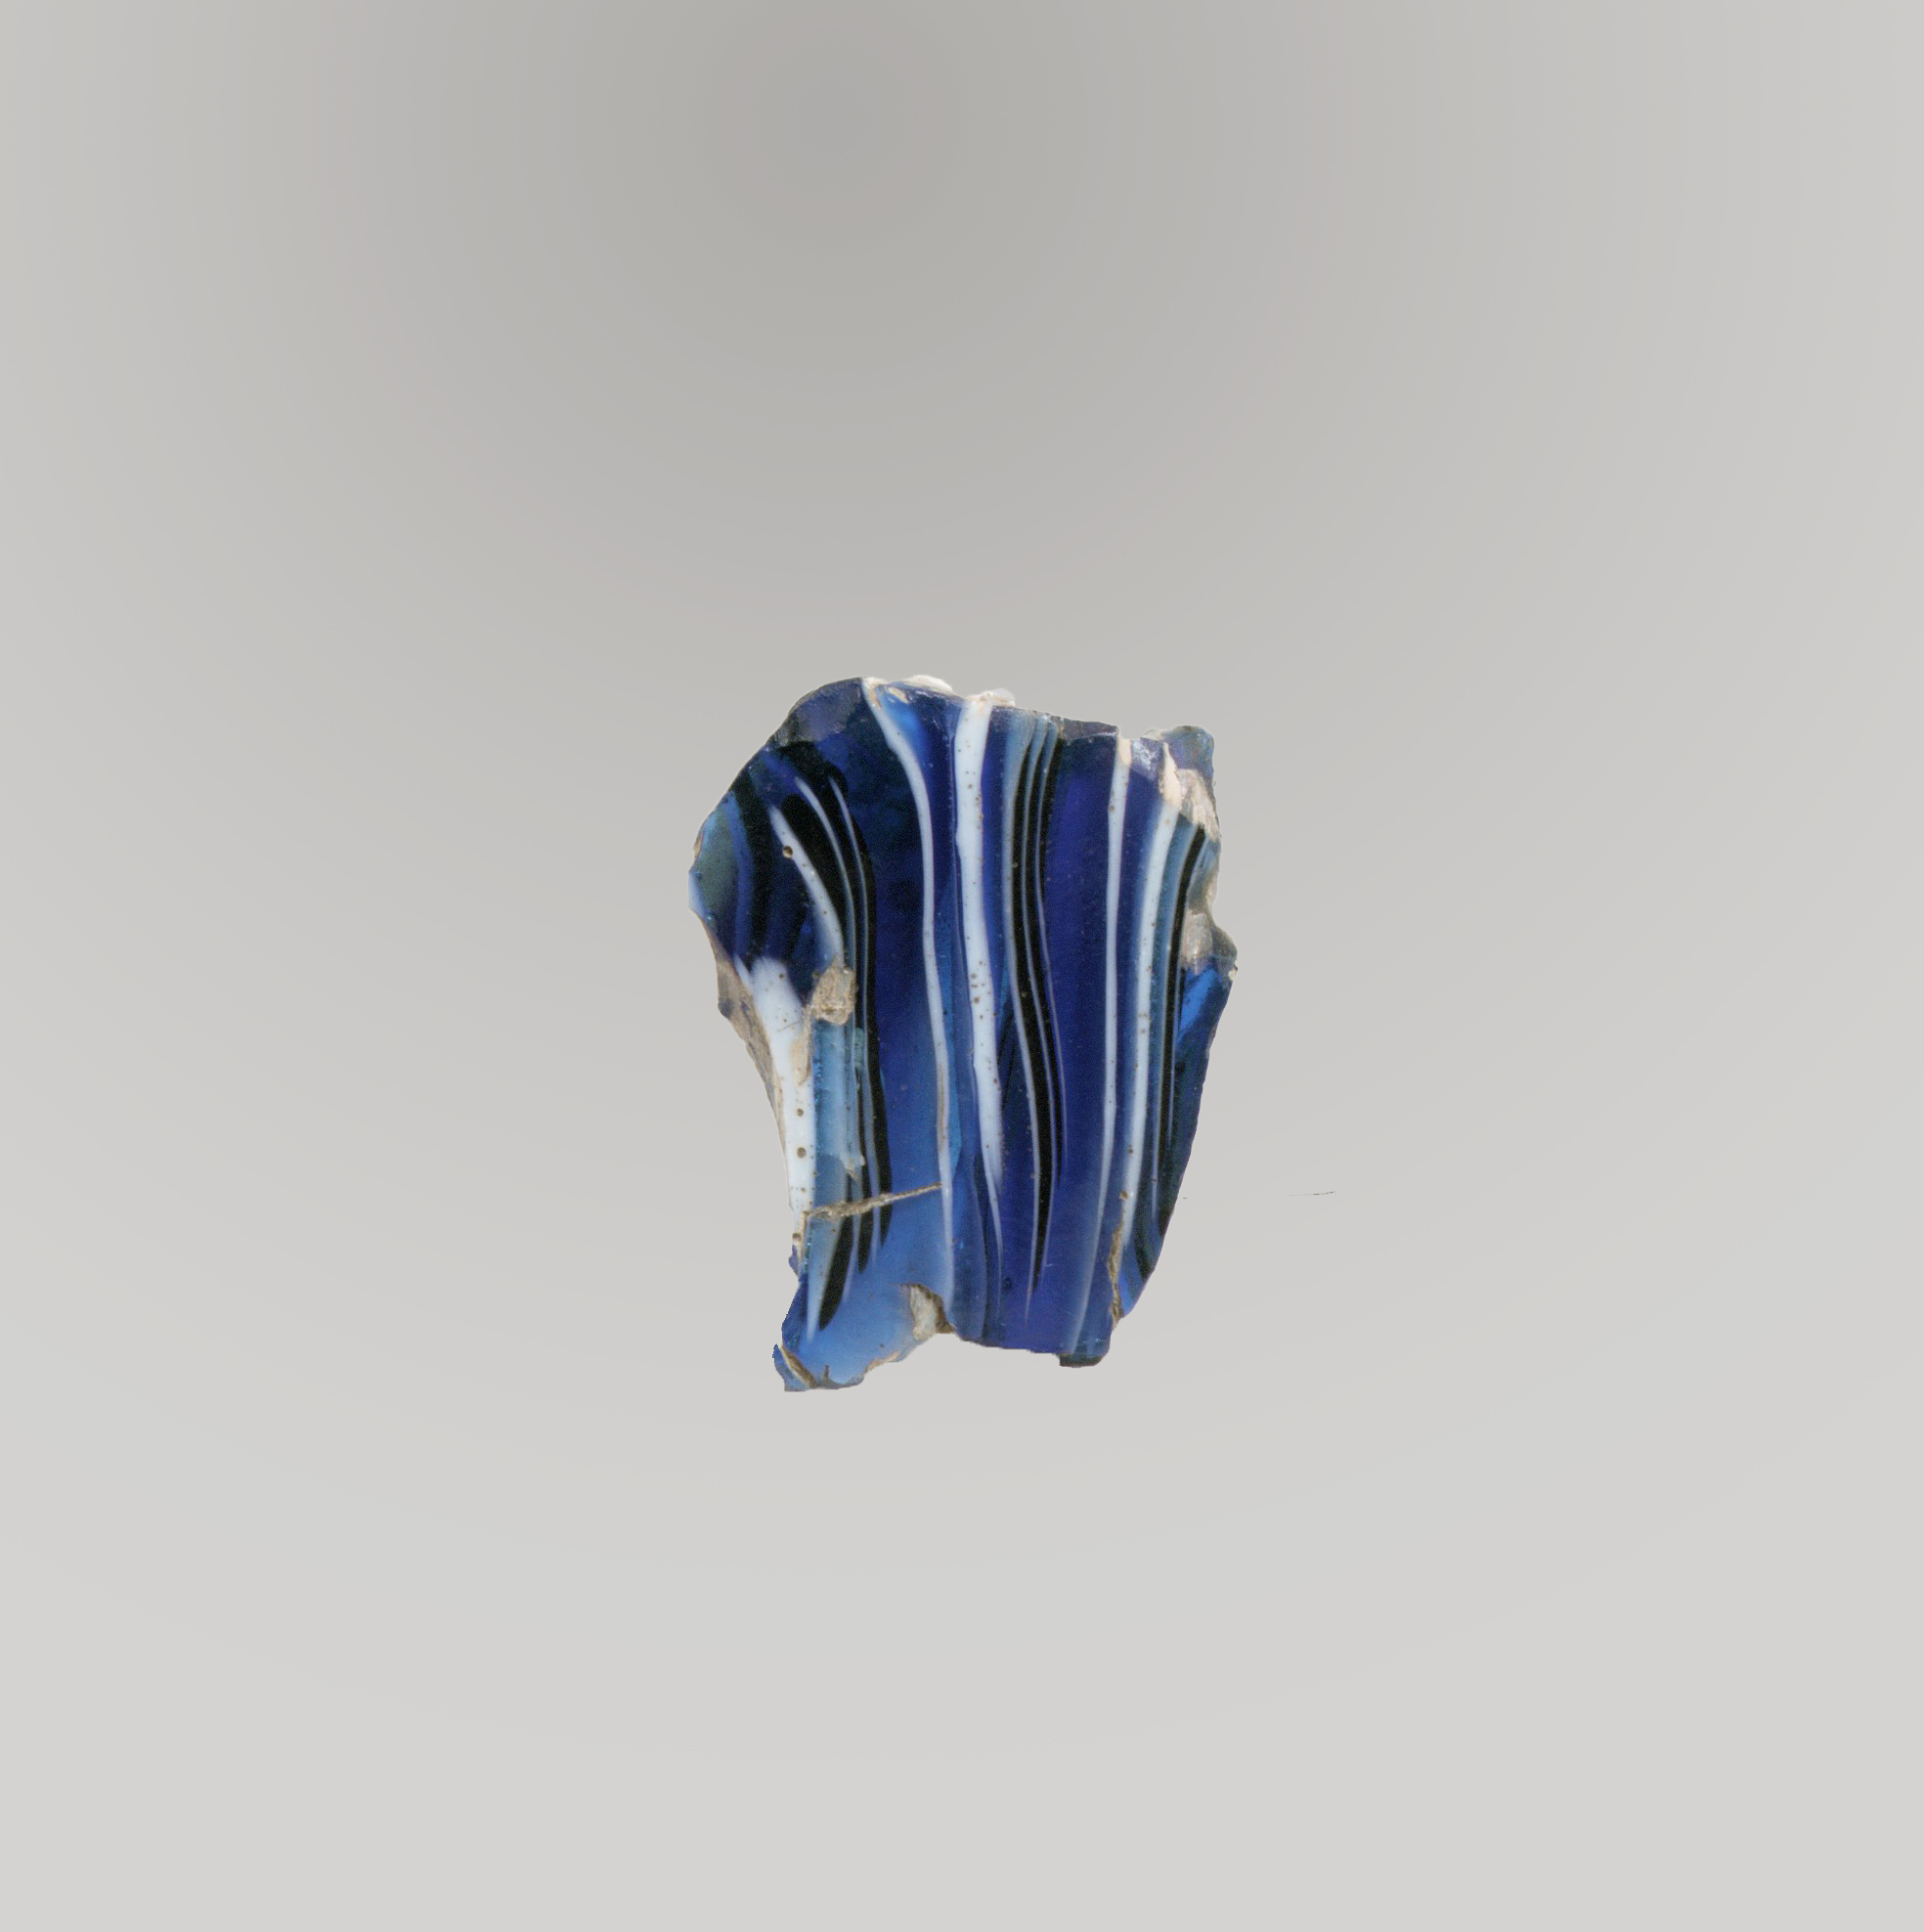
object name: fragment, mosaic bowl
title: Glass mosaic ribbed bowl fragment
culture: roman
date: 34 BCE-33 CE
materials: glass